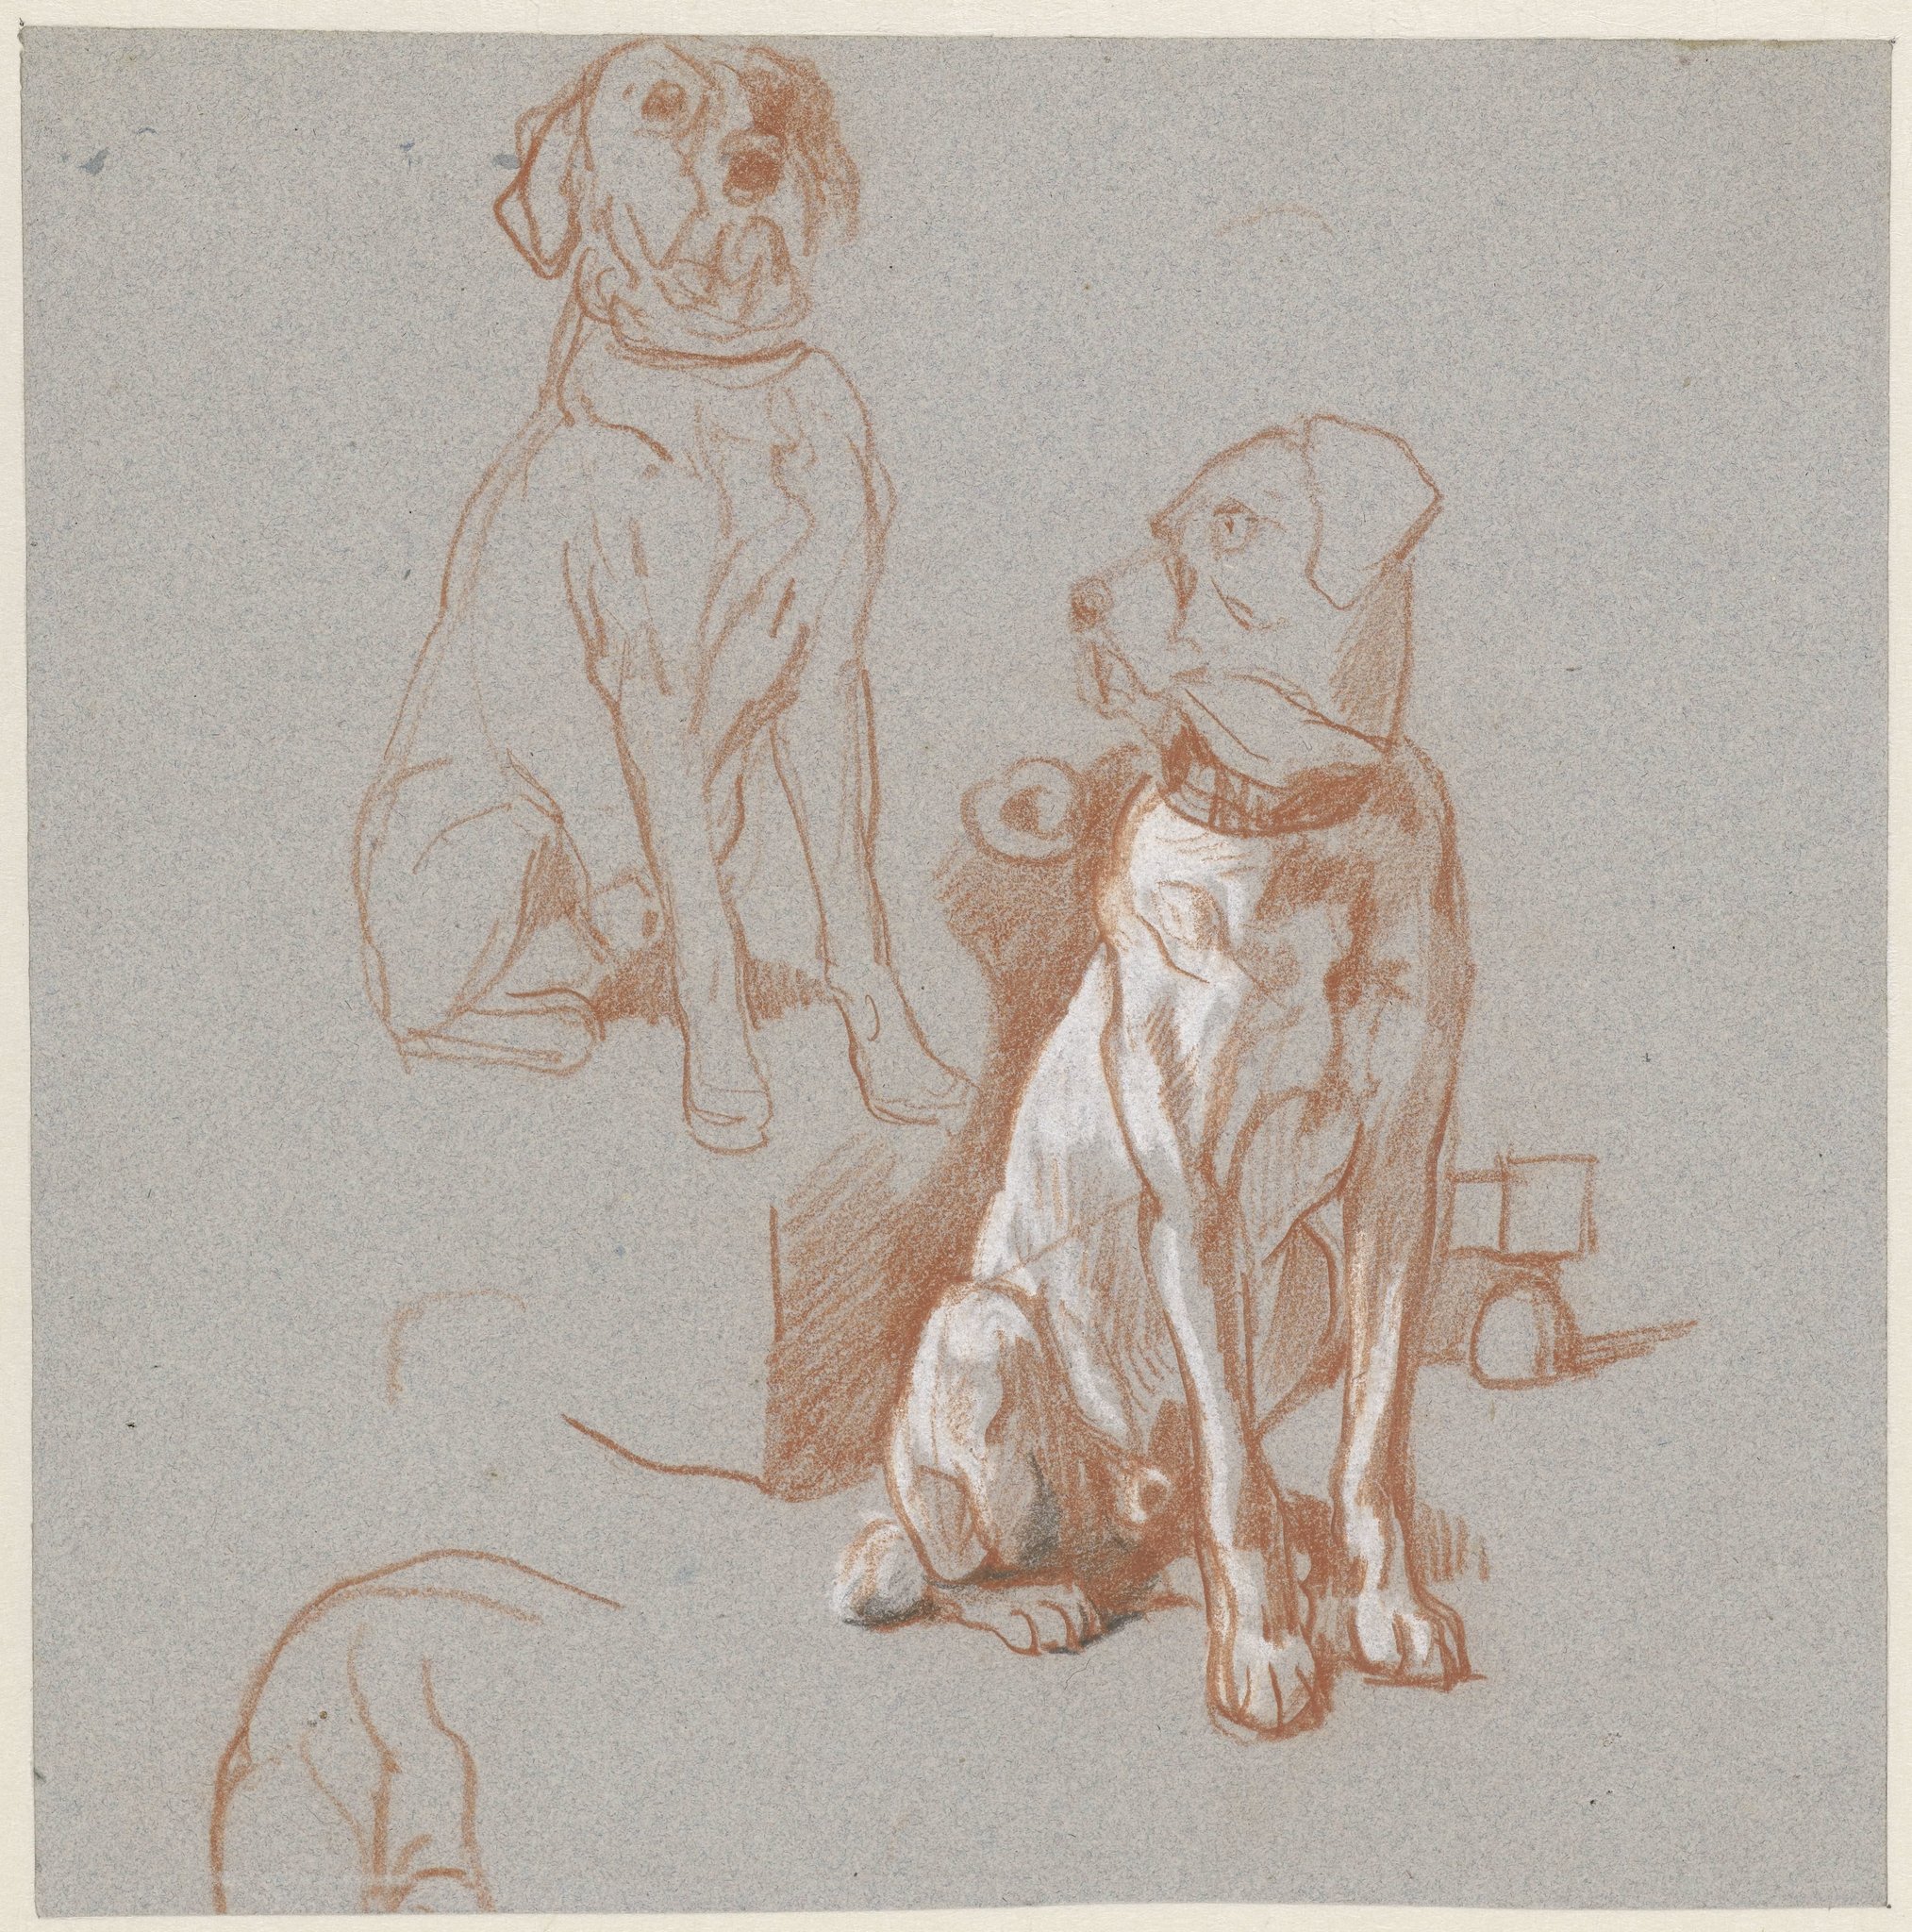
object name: drawing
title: Twee studies van een zittende hond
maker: guillaume anne van der brugghen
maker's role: draughtsman, print maker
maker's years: 1812-1891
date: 1821-1891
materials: chalk, paper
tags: dog